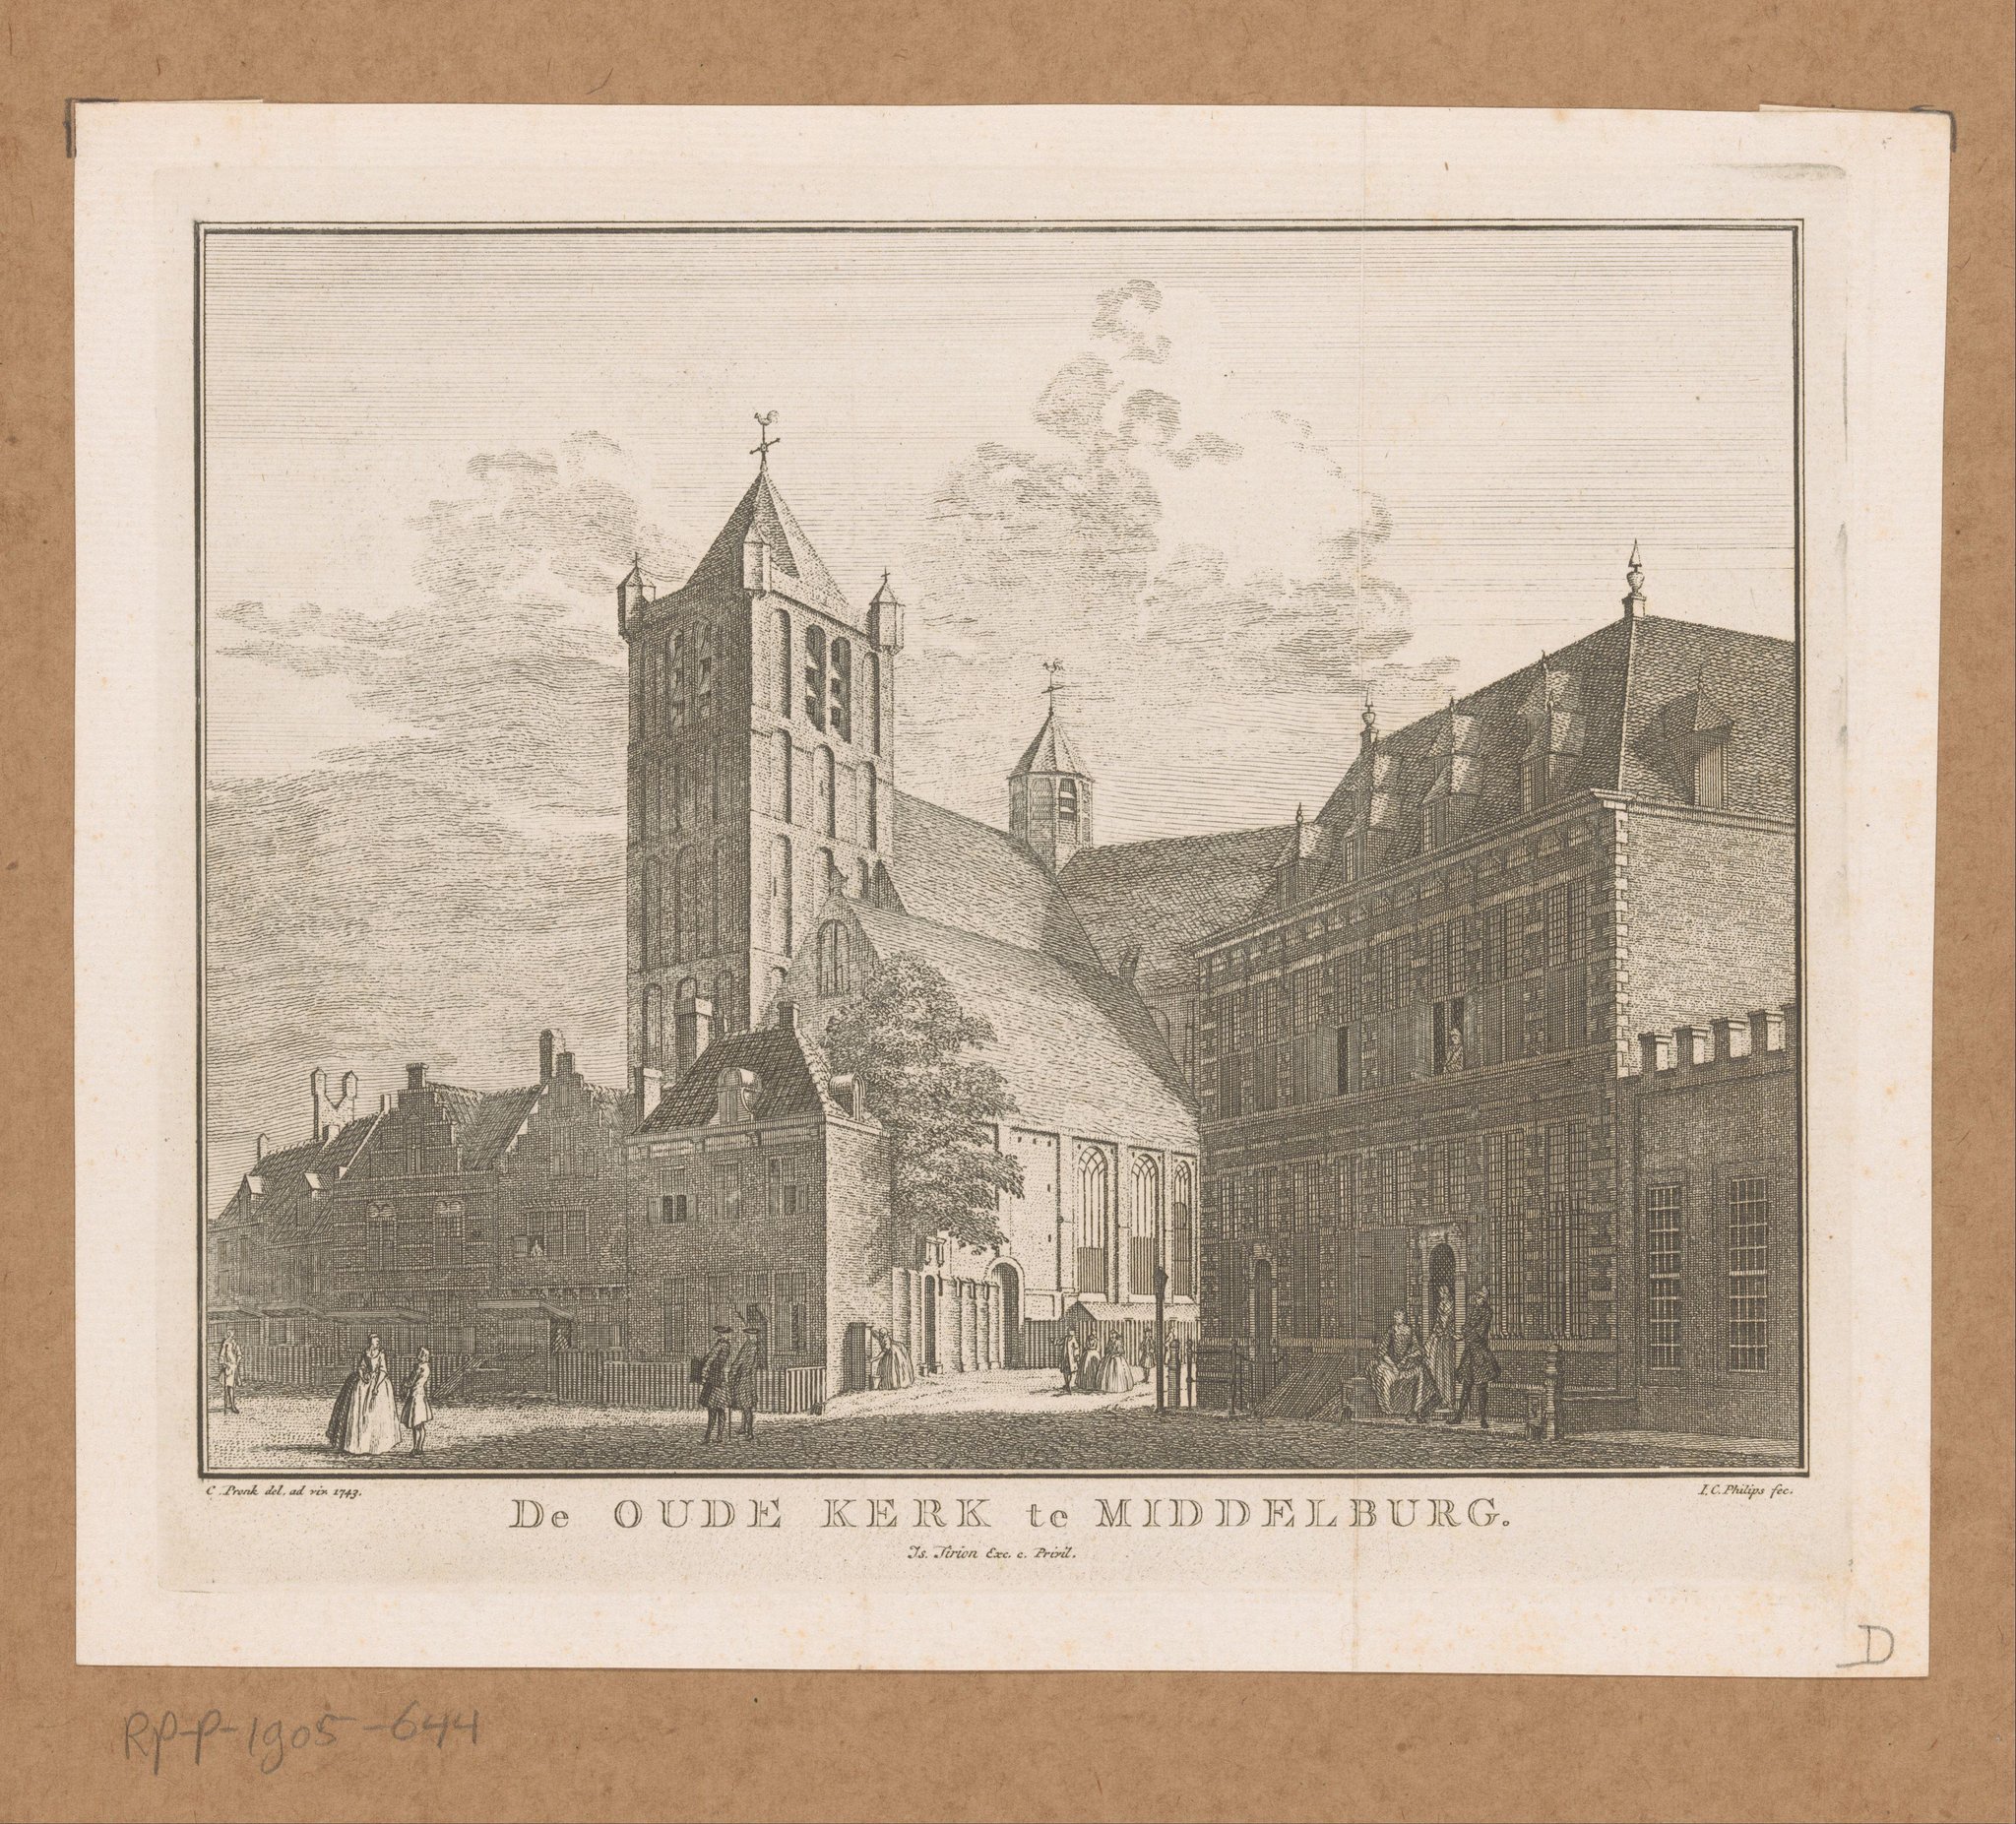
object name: book illustration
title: Gezicht op de Noordmonsterkerk te Middelburg, 1743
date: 1751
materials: paper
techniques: etching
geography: amsterdam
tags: church (exterior), street (+ city(-scape) with figures, staffage)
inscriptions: collector's mark: Lugt 2228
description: Prent ook gebruikt in: Boddaert, Pieter et al. Tegenwoordige staat der Vereenigde Nederlanden (...). Amsterdam: Isaak Tirion, 1751, dl. 9. Zie RP-P-AO-15-161-2 voor proefdruk.